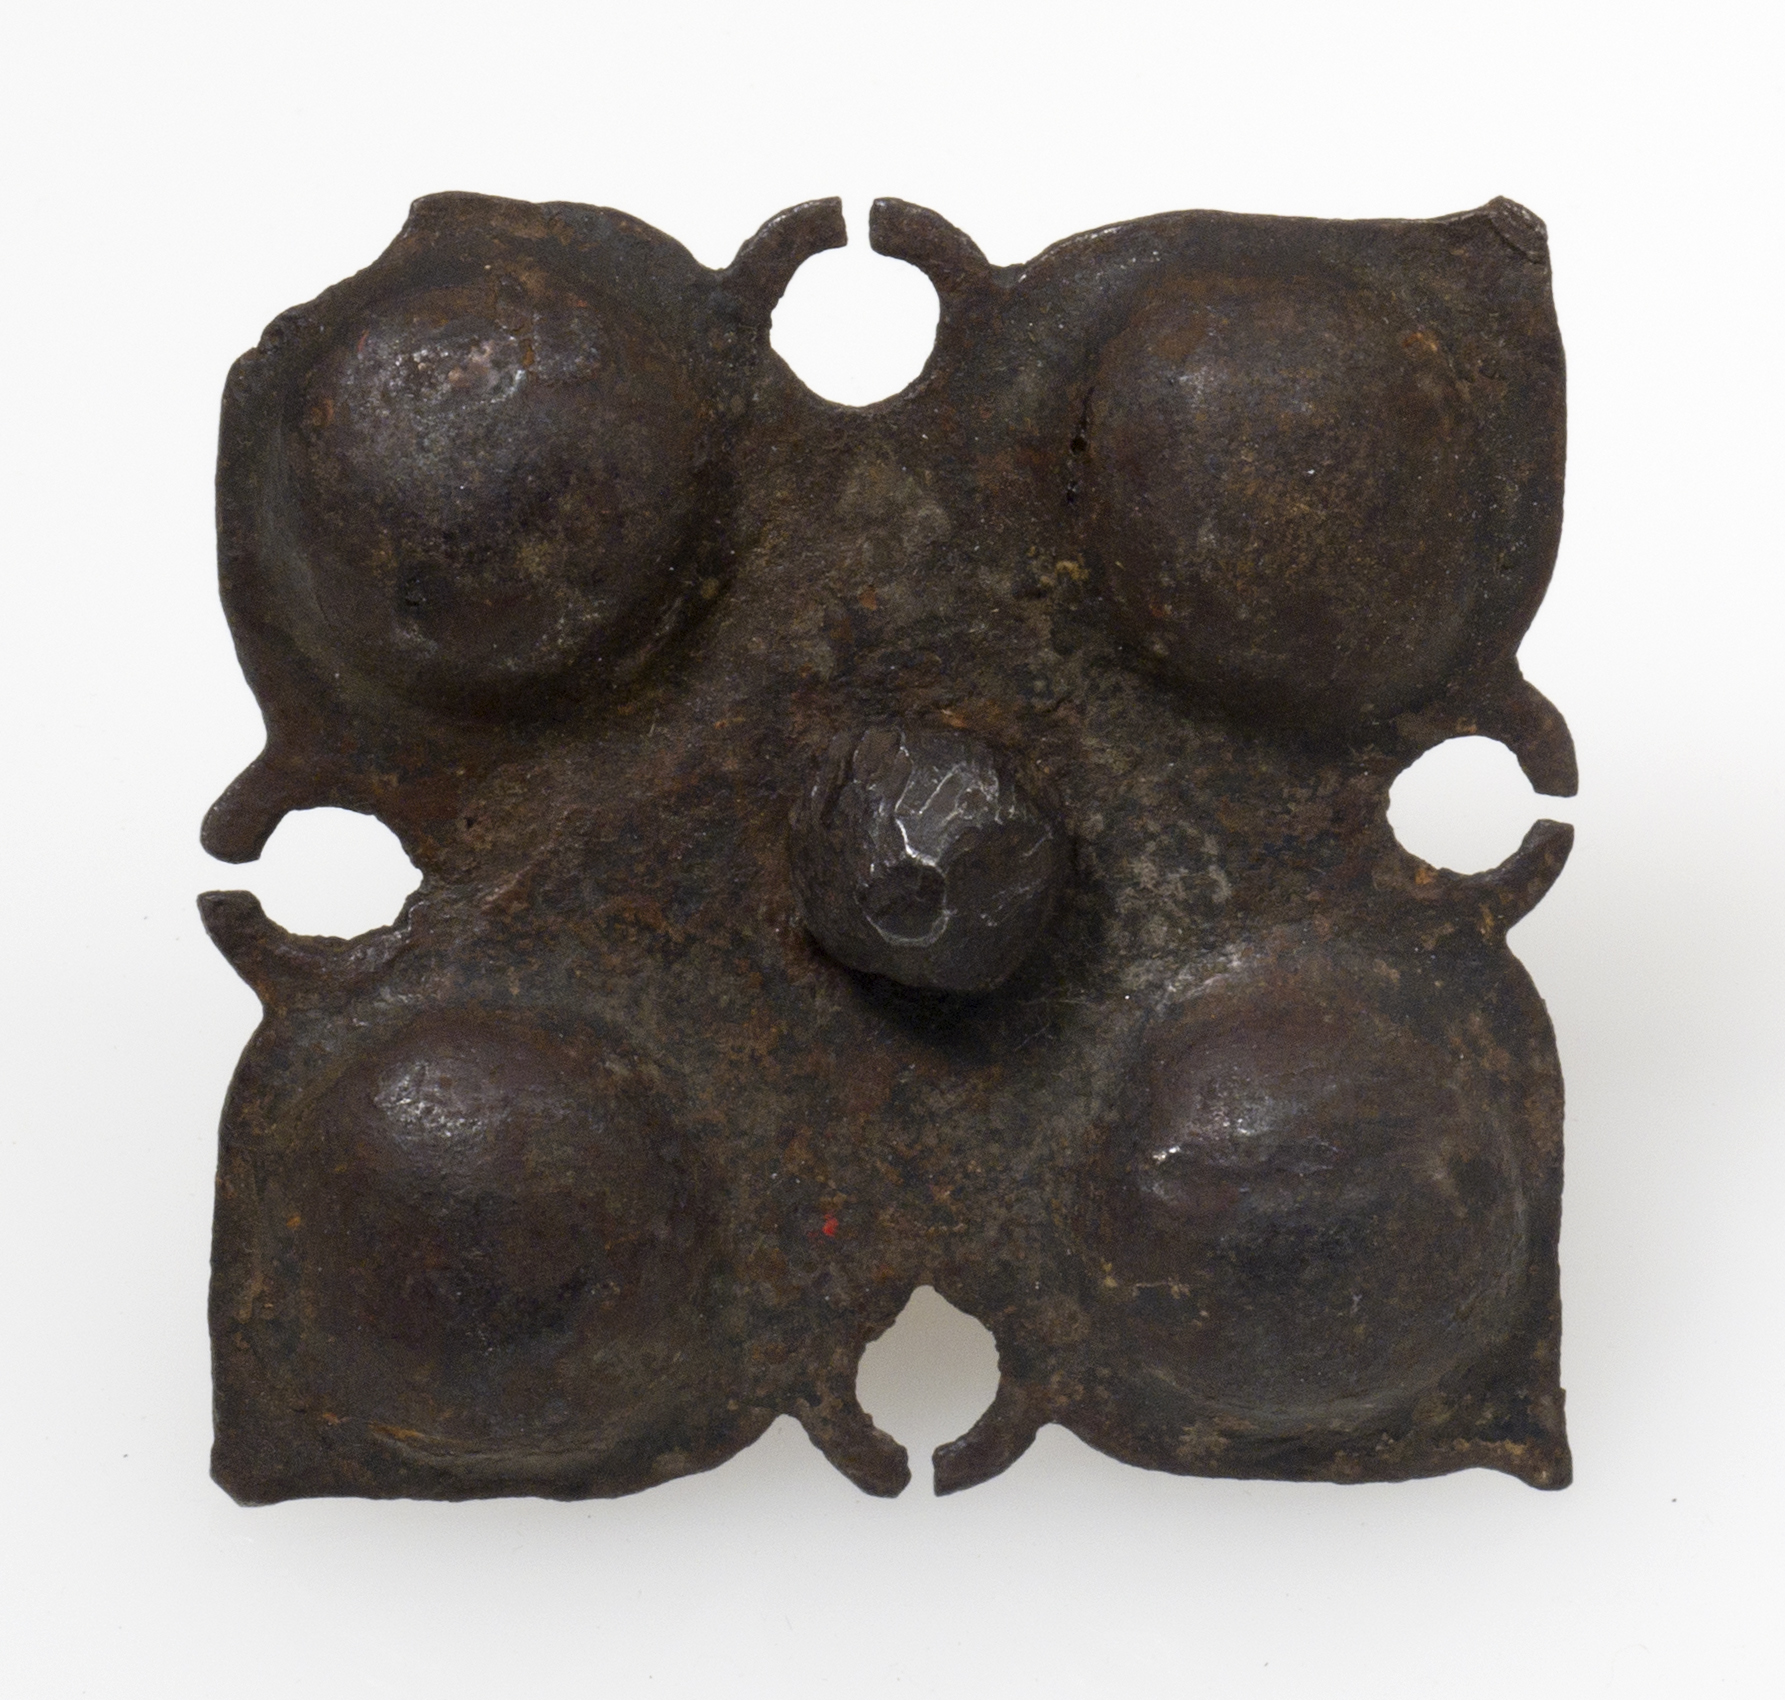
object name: plate and nail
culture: european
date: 1401-1600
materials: iron